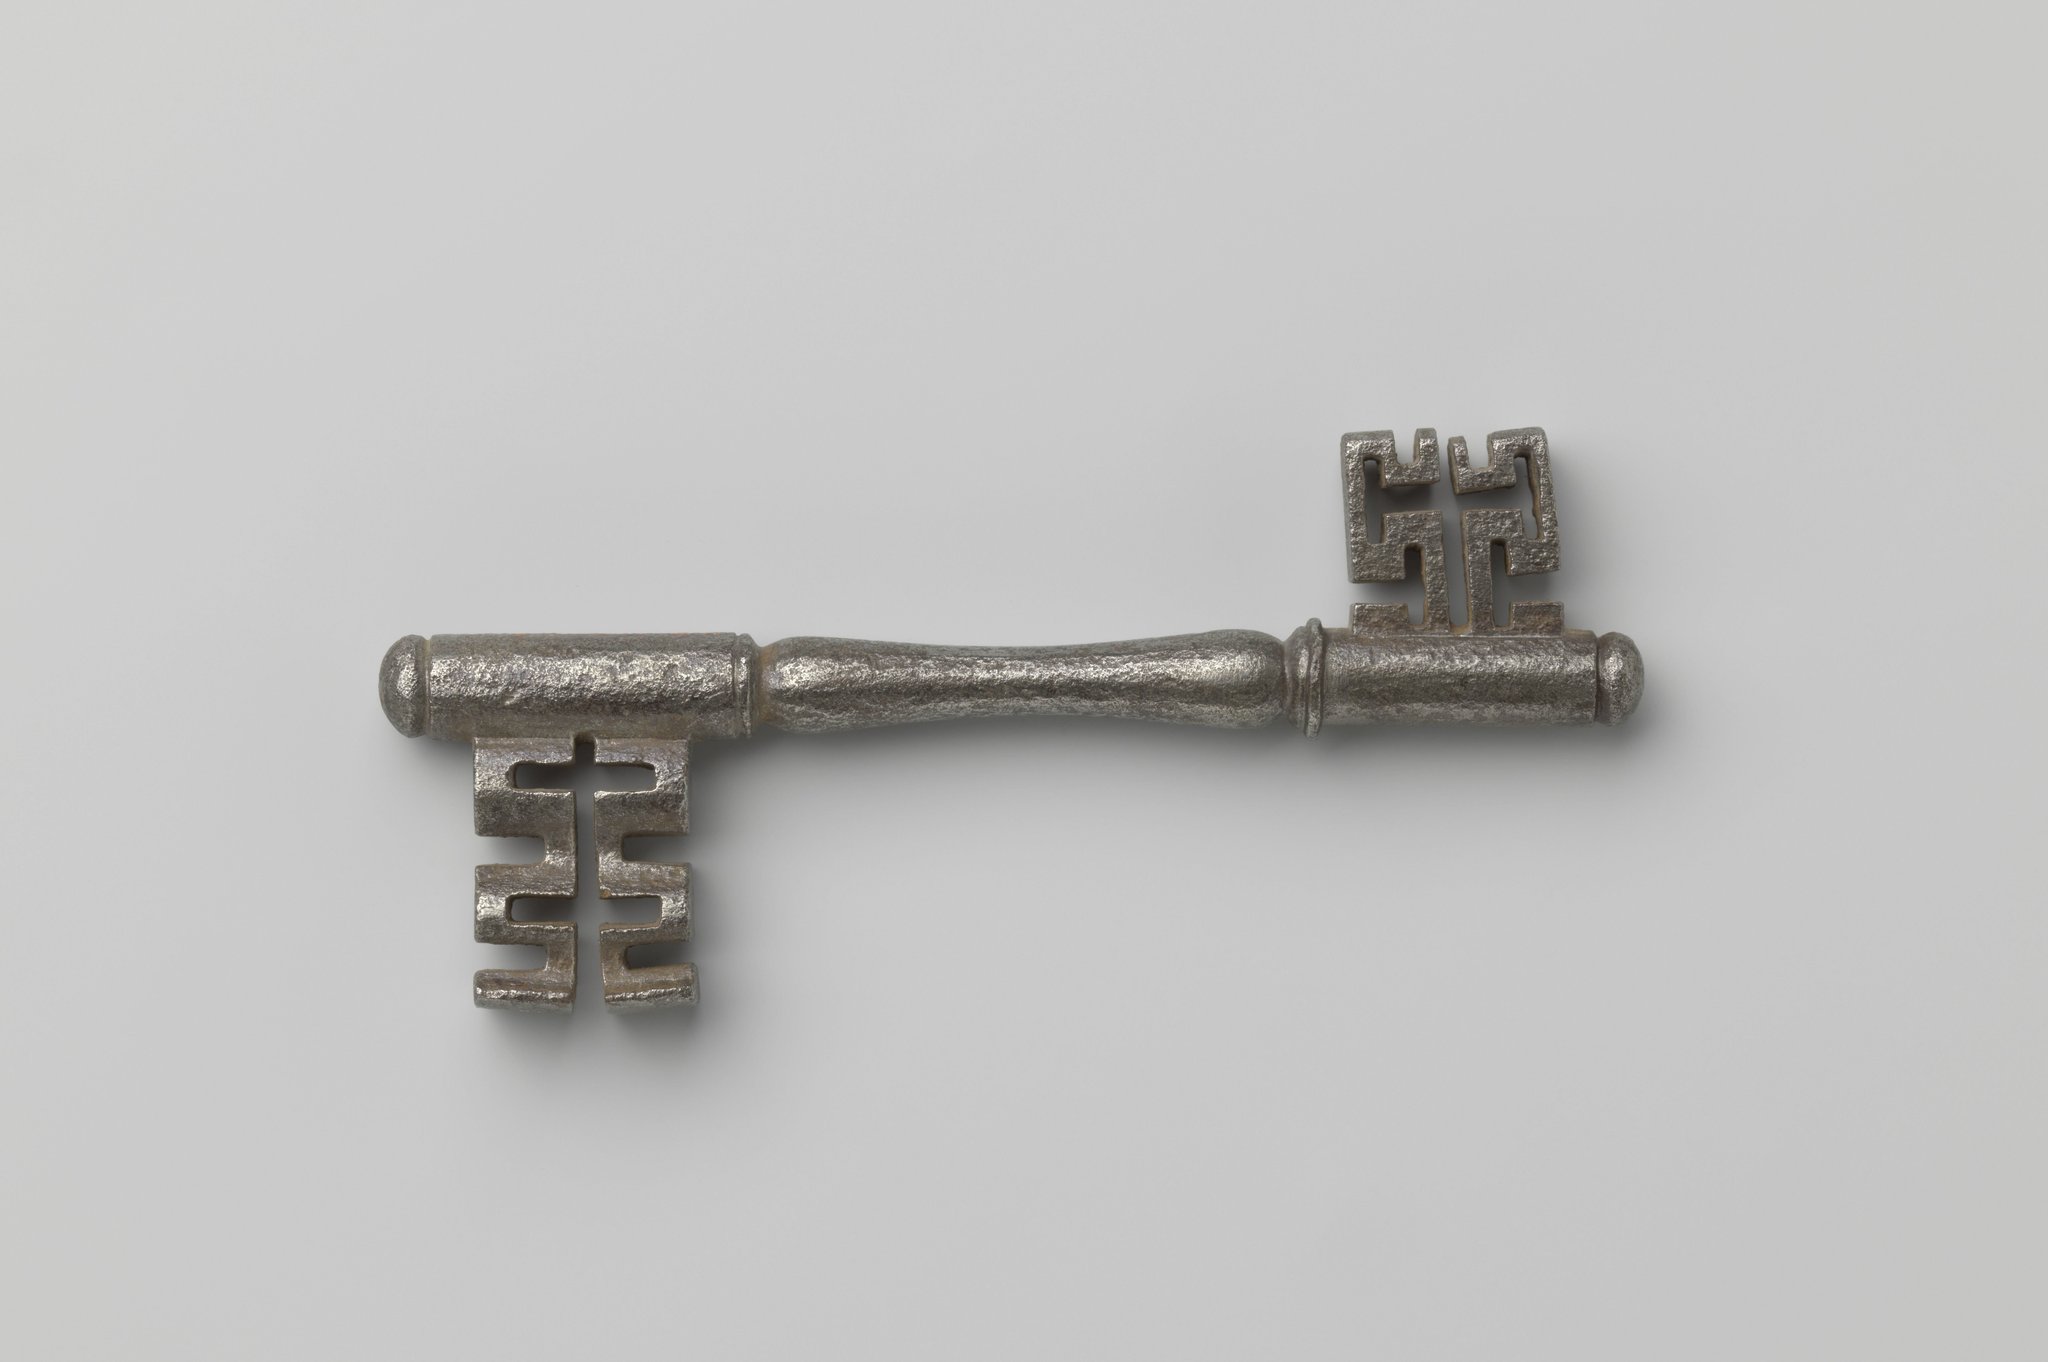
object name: key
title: Dubbele sleutel met twee baarden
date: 1600-1699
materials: iron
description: Dubbele sleutel met twee baarden die aan weerszijden van de beide uiteinden van de balustervormige schacht bevestigd zijn.